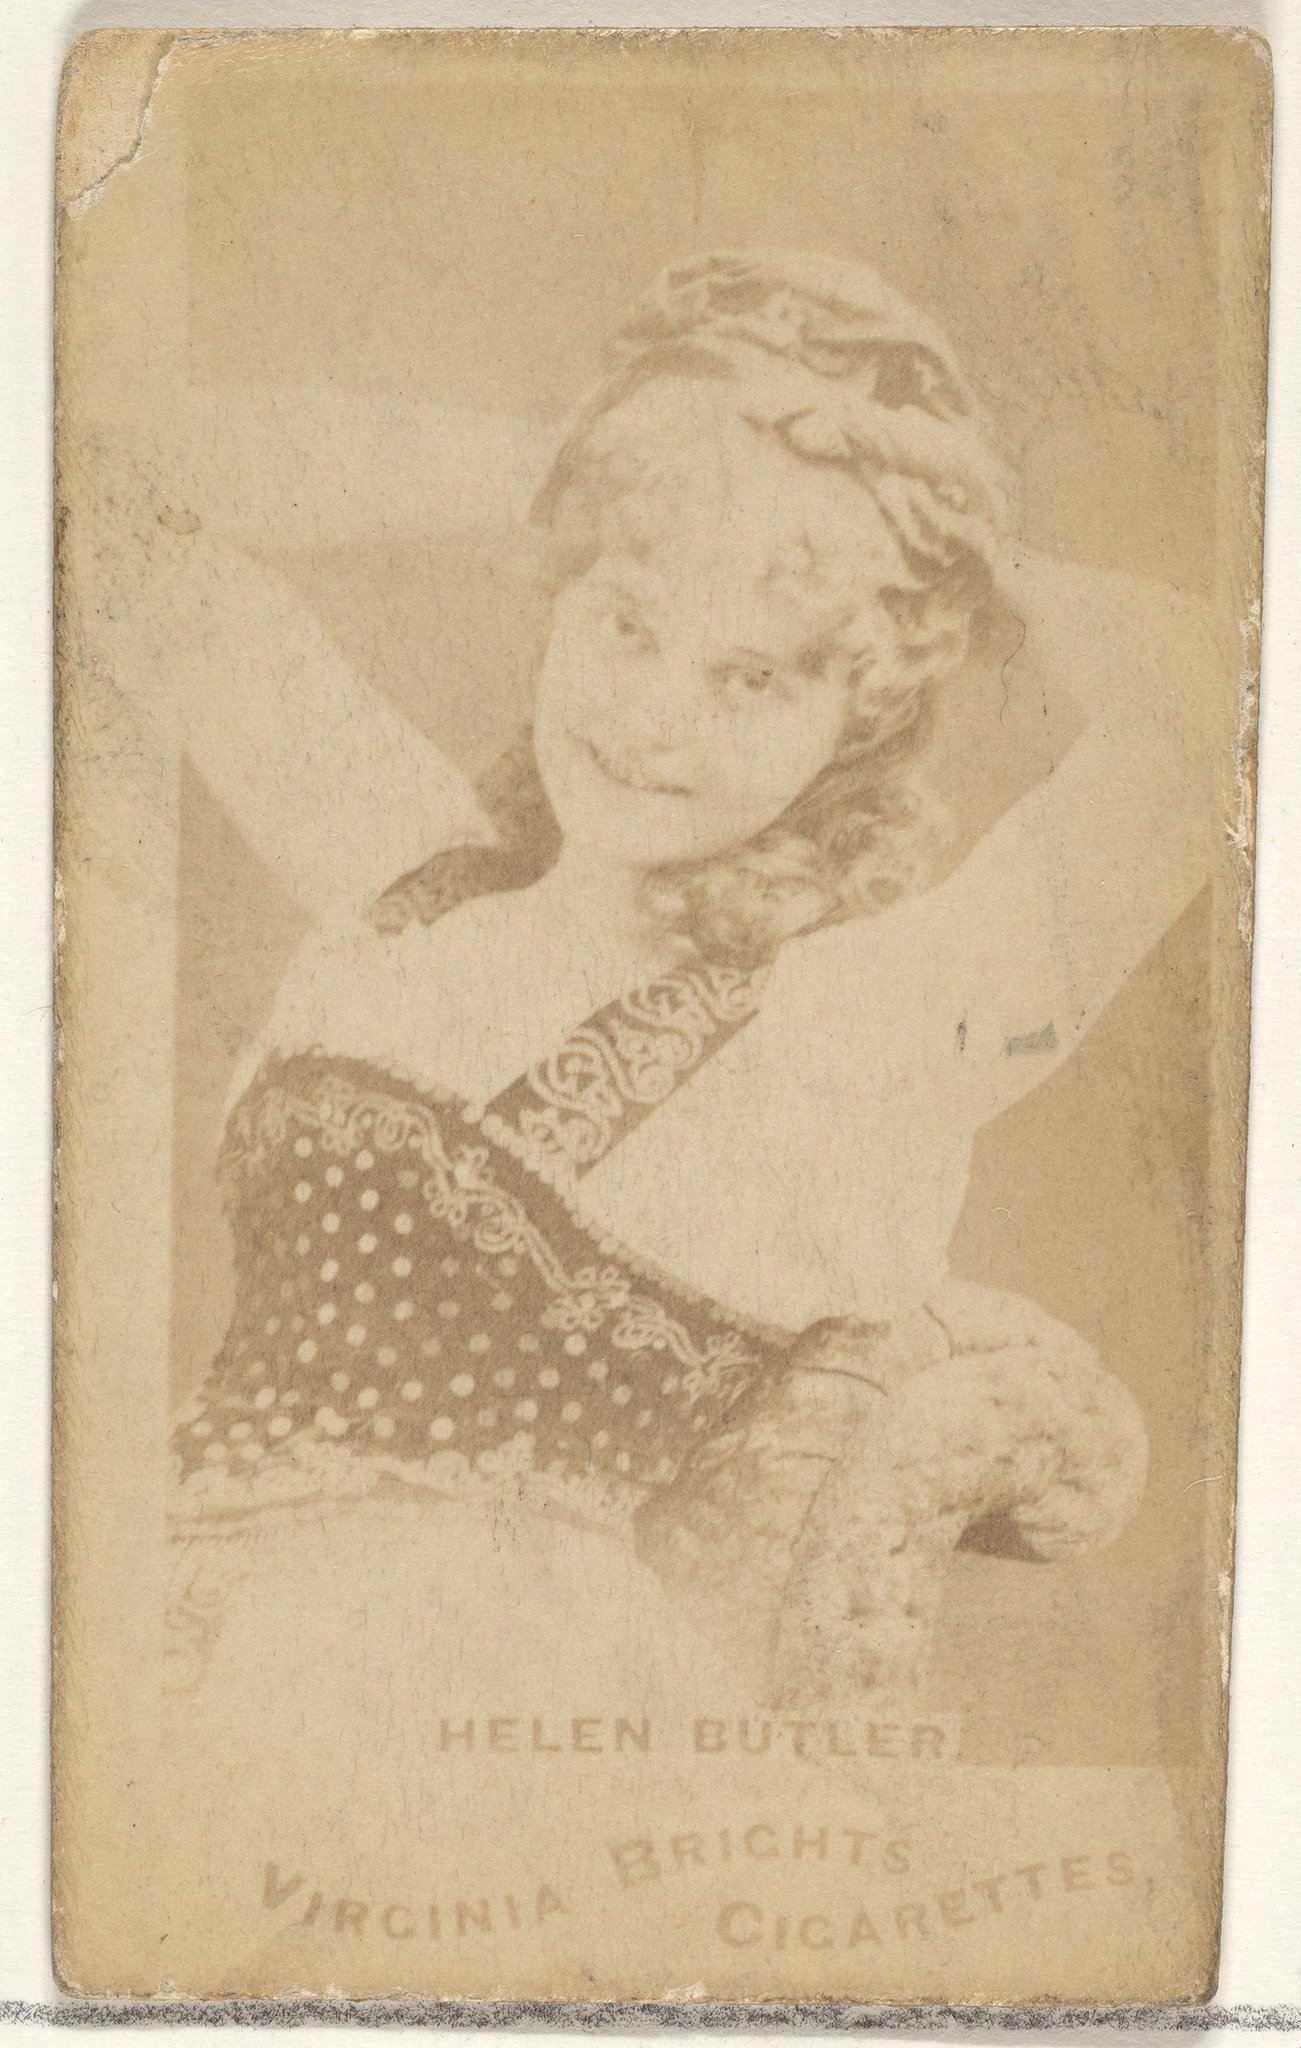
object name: photograph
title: Helen Butler, from the Actors and Actresses series (N45, Type 1) for Virginia Brights Cigarettes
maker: allen & ginter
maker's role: publisher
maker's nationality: american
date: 1888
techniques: albumen silver print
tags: portraits,women,actresses